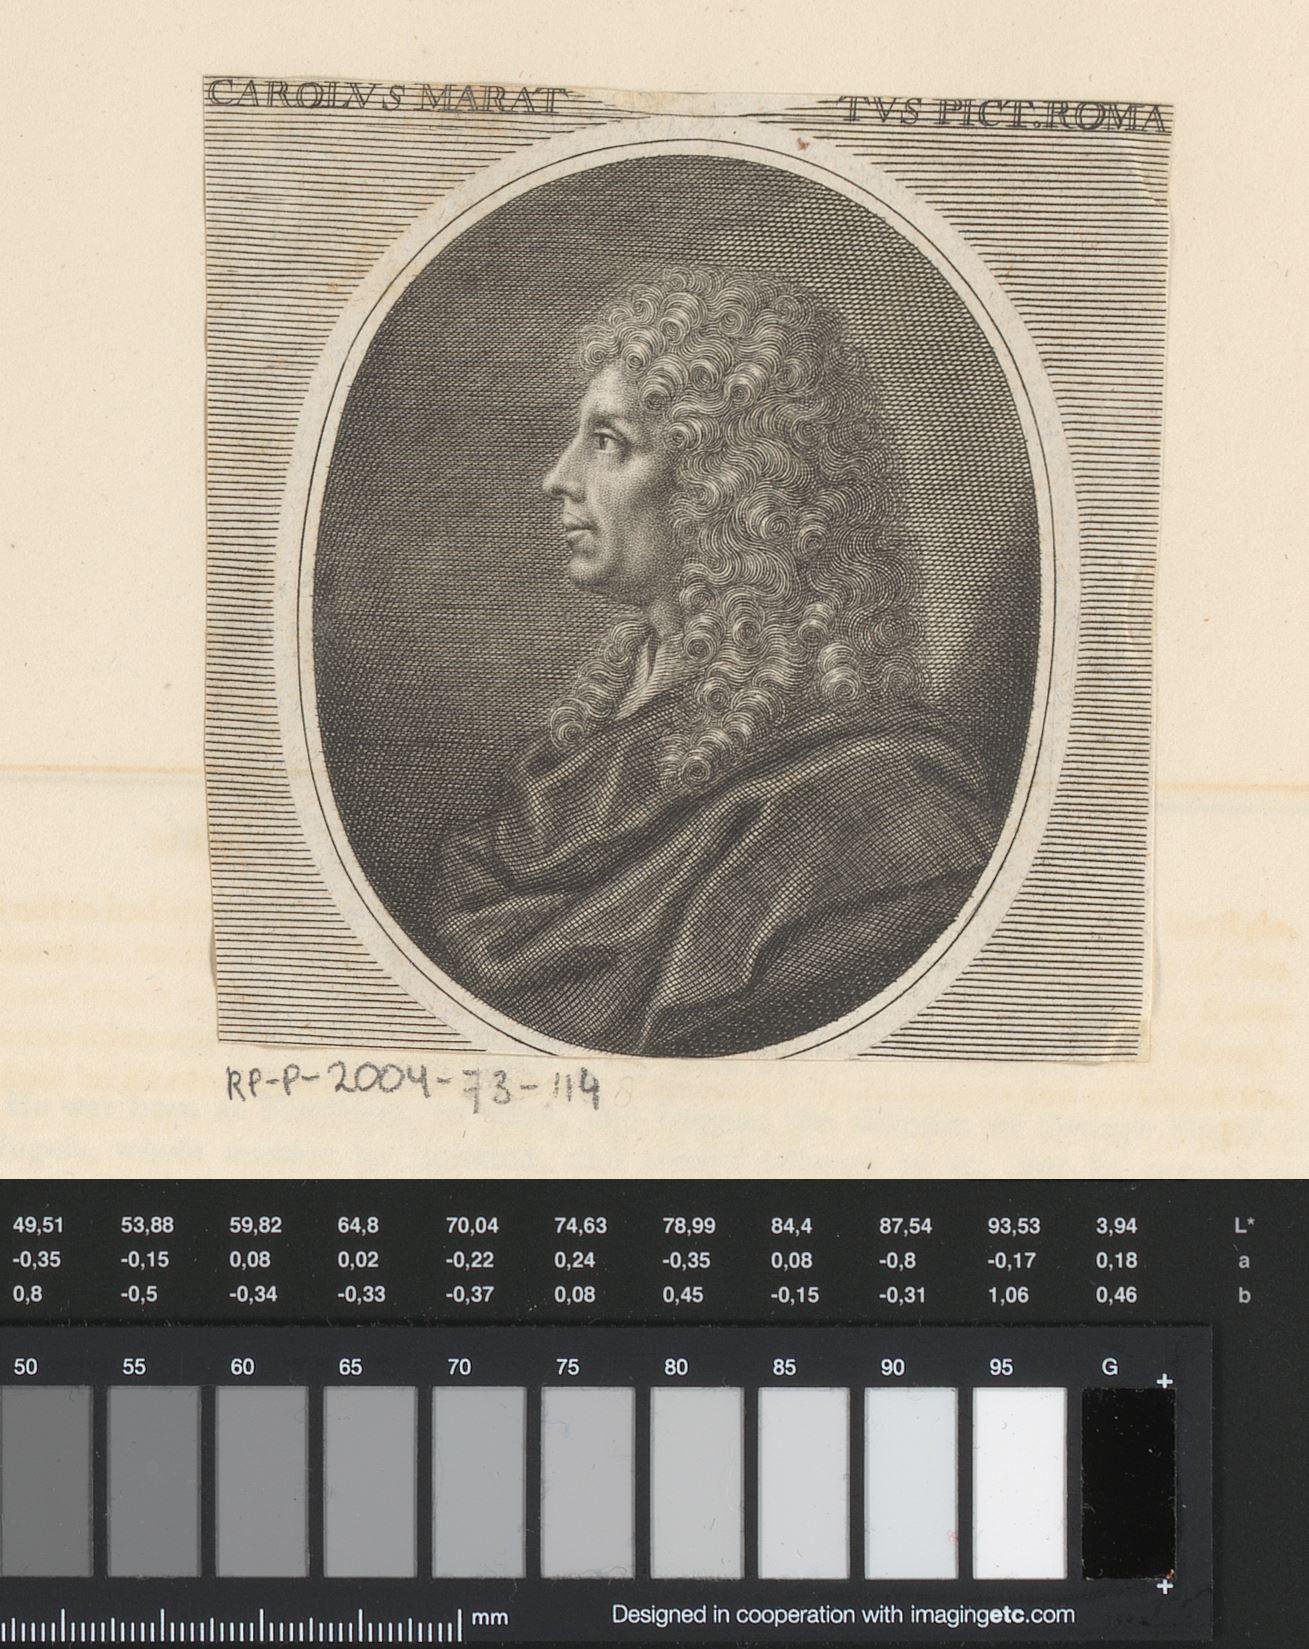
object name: book illustration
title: Carolus Marat tus Pict. Roma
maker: leonhard heckenauer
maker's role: print maker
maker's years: 1650-1704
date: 1768-1775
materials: paper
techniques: engraving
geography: nuremberg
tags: rome, draughtsman, carlo maratta, historical persons, portrait, self-portrait of painter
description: Prent uit: Sandrart, Joachim von. Teutsche Academie der Bau- Bildhauer- und Maler-Kunst: worinn die Regeln und Lehrsätze dieser Künste gegeben. 14 dln. Neurenberg: erven Johann Andreas Endter, [1774], dl. 7, p. SS. De samensteller heeft deze prent in het album geplakt als illustratie bij: Pilkington, Matthew en Johann Heinrich Füssli. A dictionary of painters, from the revival of the art to the present period. 4 dln. Londen: John Crowder, 1805, dl. 2, p. 316.